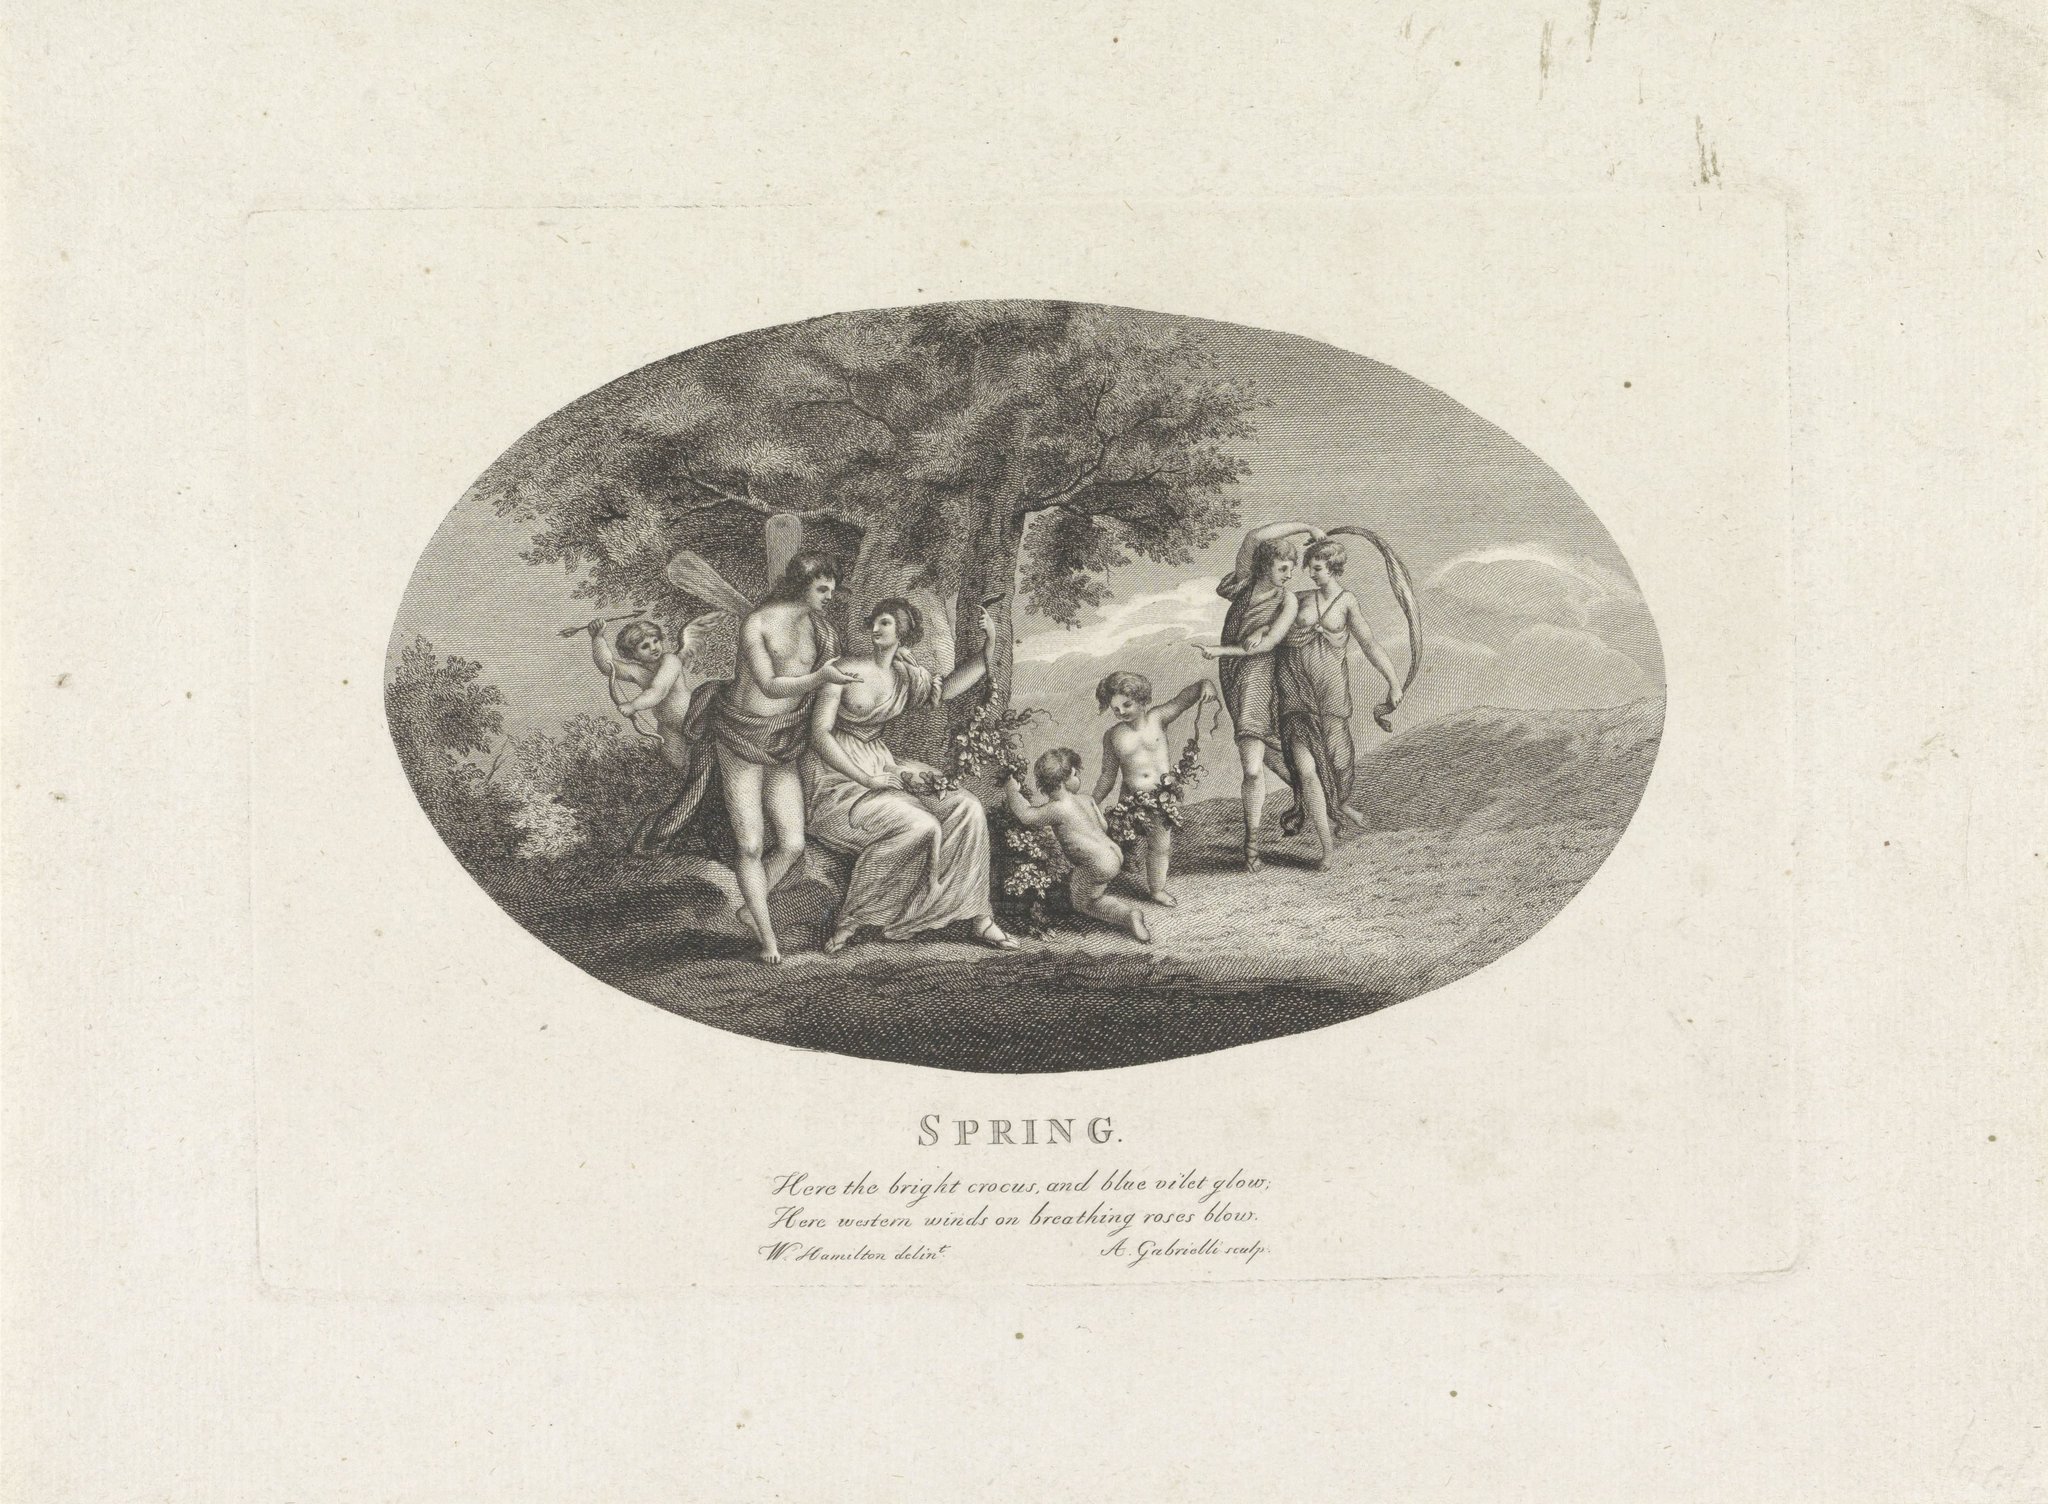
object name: print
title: De vier seizoenen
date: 1759-1817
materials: paper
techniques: engraving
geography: italy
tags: spring landscape; landscape symbolizing spring (the four seasons of the year), cupids: 'amores', 'amoretti', 'putti'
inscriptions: collector's mark: Lugt 2228, collector's mark: Lugt 2760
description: Figuren en putti in een landschap. Een voorstelling van de lente.